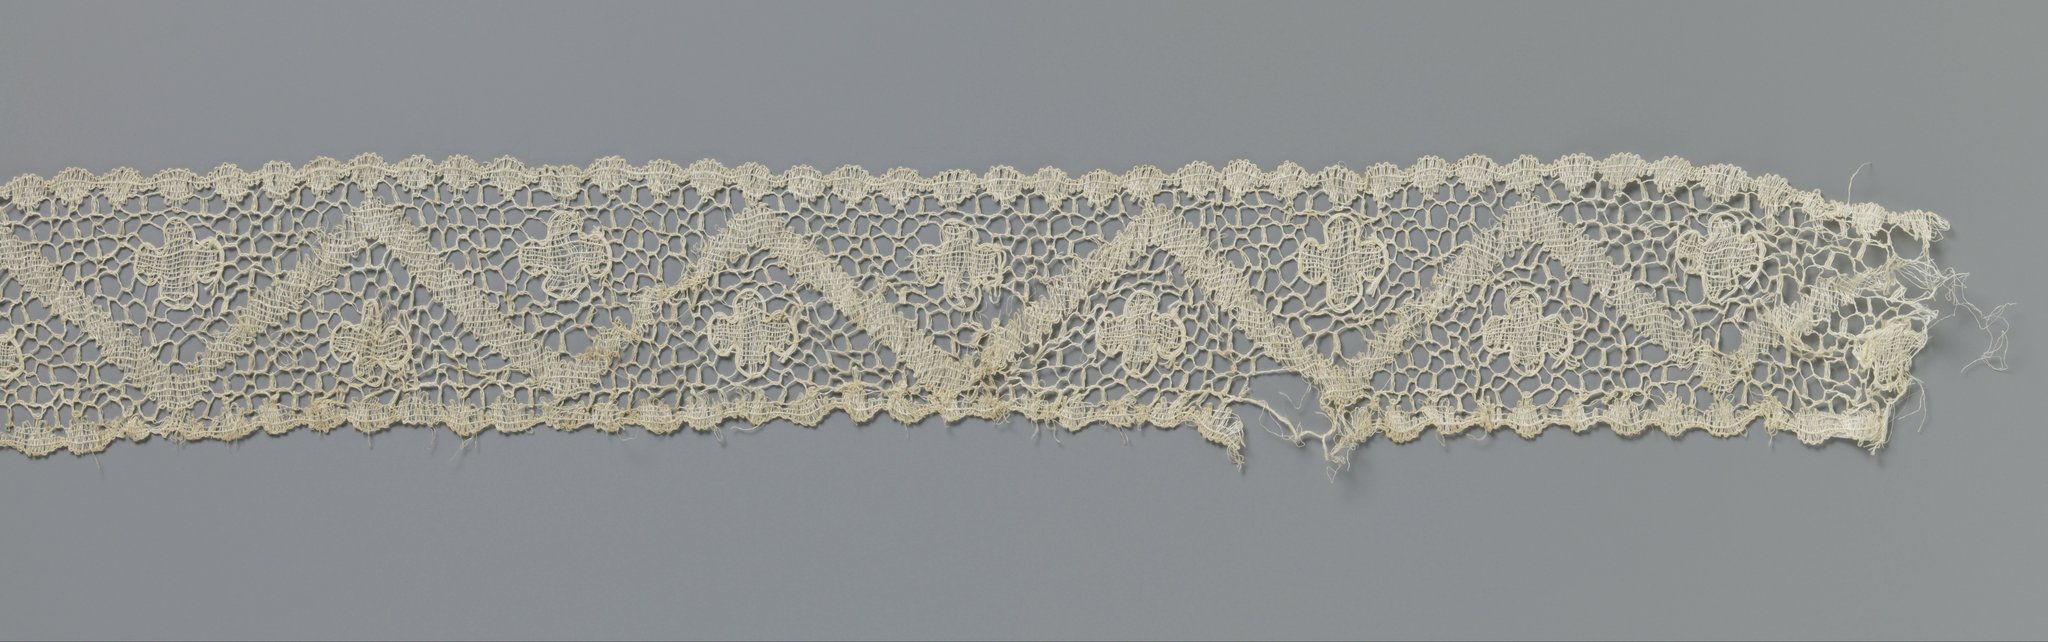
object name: strip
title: Strook kloskant met vierlobbig rozet boven en onder een zigzag-band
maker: Anonymous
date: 1840-1860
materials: silk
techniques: lace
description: Strook naturelkleurige kloskant, blonde. Het zich herhalende en doorlopende patroon bestaat uit een zigzag-band, die de strook in driehoekige velden verdeeld. In het centrum van elk veld staat een vierlobbig rozet. Langs de boven- en onderzijde van de strook loopt een schulprand, die bestaat uit een aaneenschakeling van cirkeltjes. De schulpranden zijn afgewerkt met picots. De motieven zijn met elkaar verbonden door een grove maasgrond, bezaaid met vierkante moesjes. De zigzag-band, rozetten en cirkeltjesranden zijn gemaakt in linnenslag, waarbij de rozetten zijn voorzien van een contourdraad.